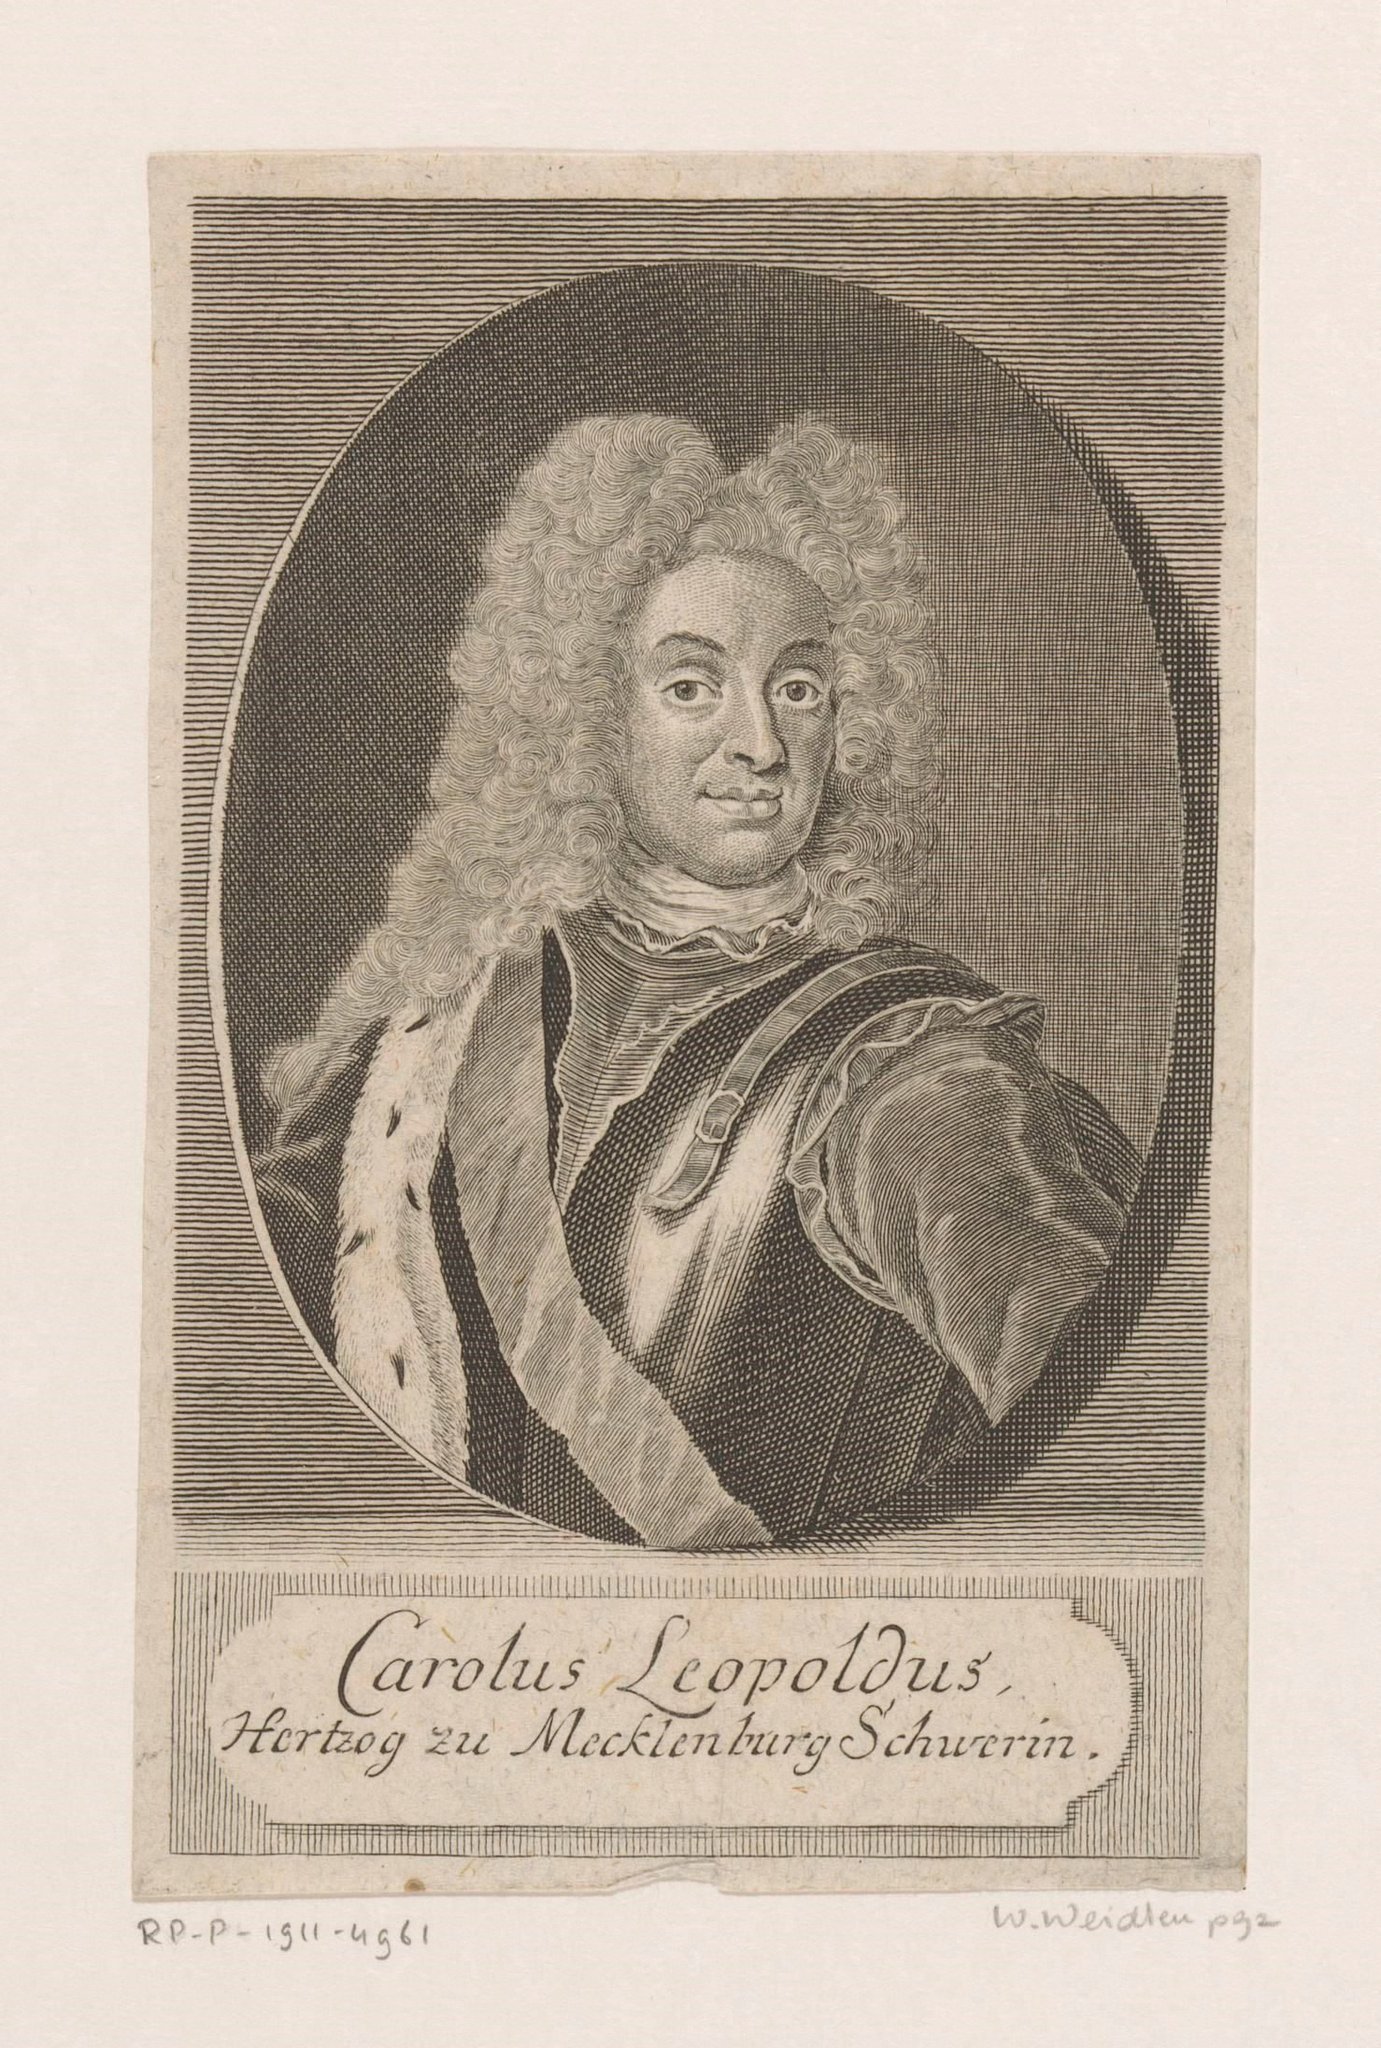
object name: print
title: Portret van Karl Leopold von Mecklenburg-Schwerin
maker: martin bernigeroth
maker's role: print maker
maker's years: 1670-1733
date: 1713-1733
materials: paper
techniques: engraving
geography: leipzig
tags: armour, historical persons, mantle, gown, dress (symbol of sovereignty)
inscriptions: collector's mark: Lugt 2228